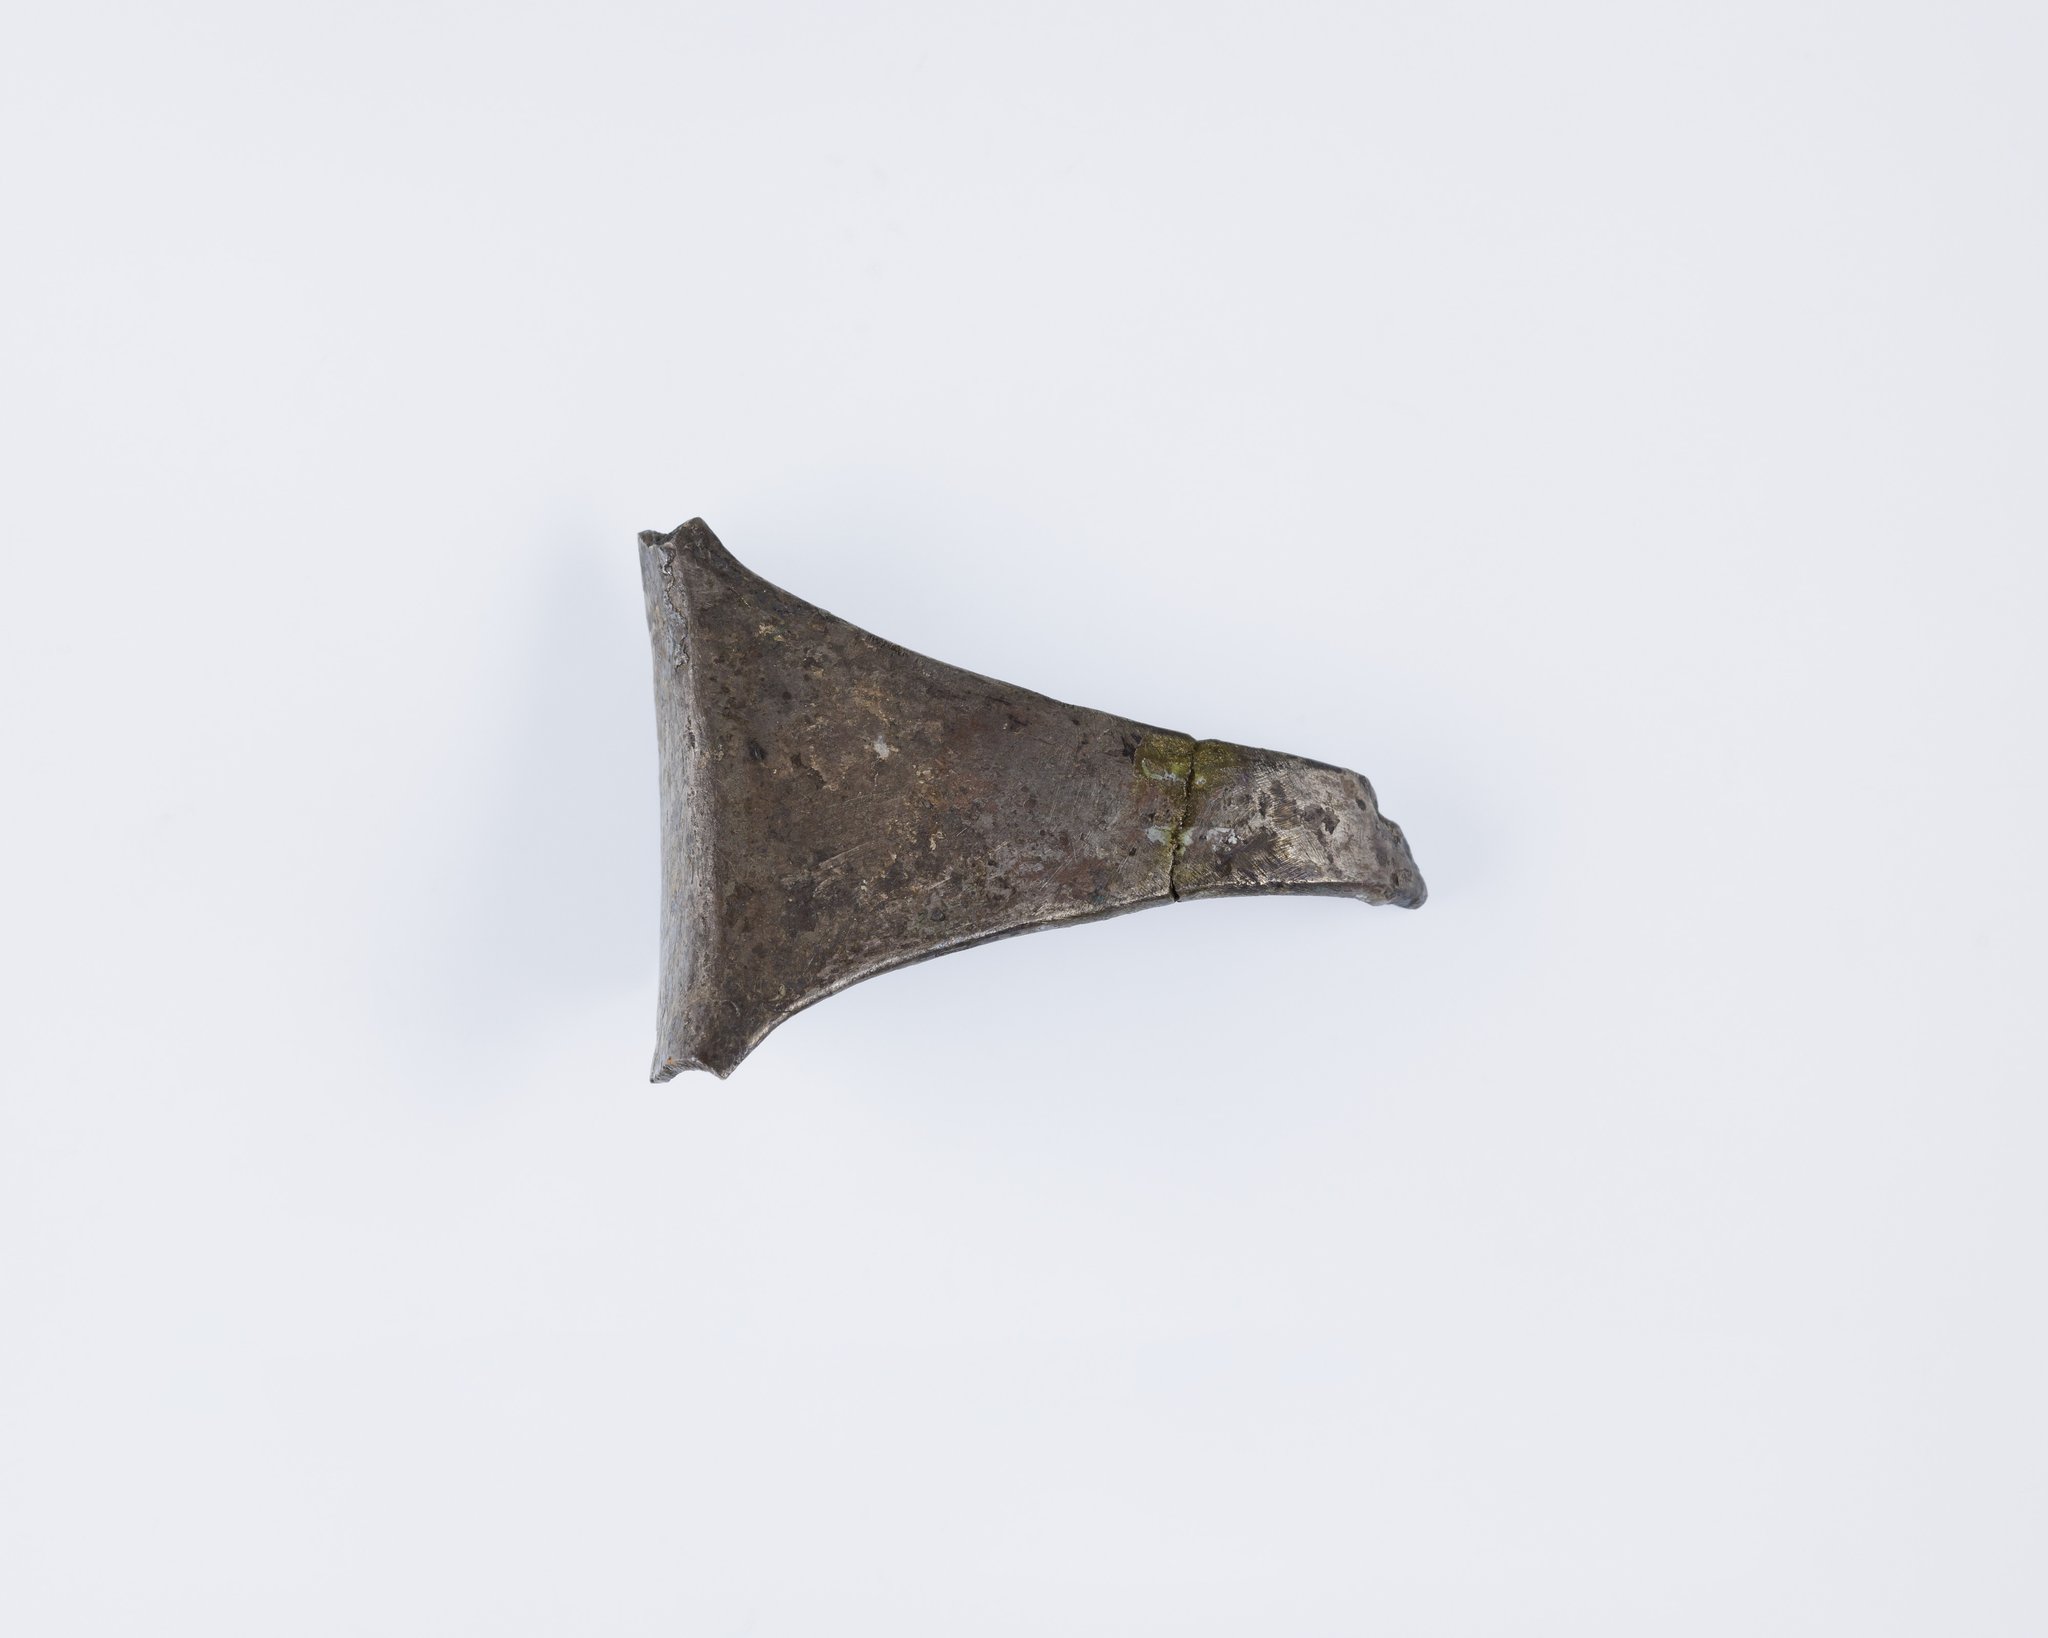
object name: strainer handle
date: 1295-1070 BCE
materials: silver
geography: egypt